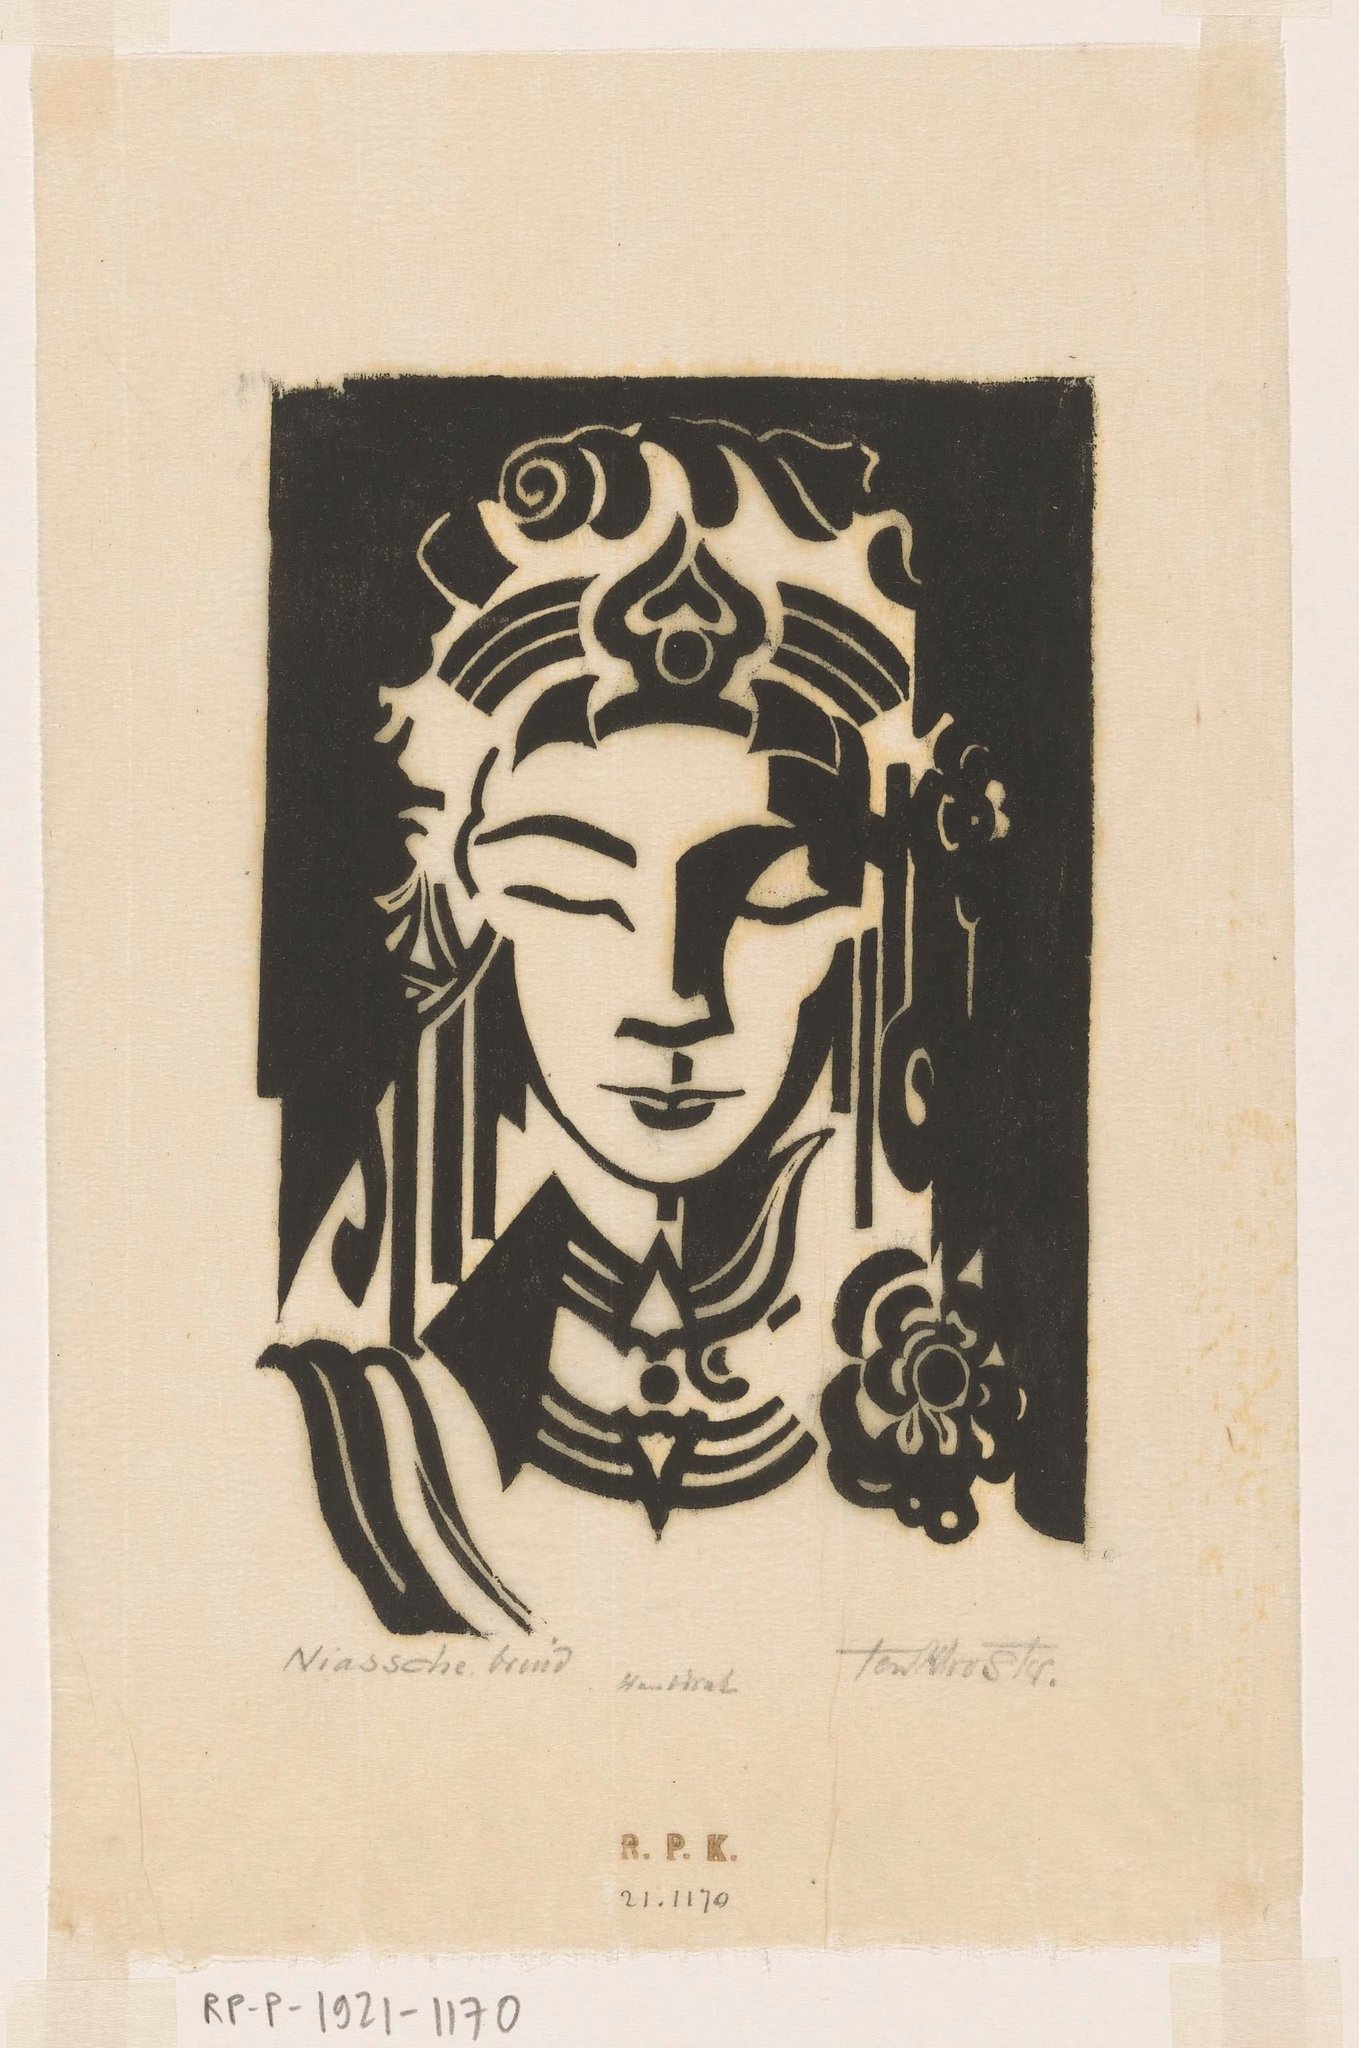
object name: print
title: Niassche bruid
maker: johannes frederik engelbert ten klooster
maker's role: draughtsman, print maker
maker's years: 1873-1940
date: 1919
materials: paper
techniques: woodcut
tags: bride (in wedding-dress)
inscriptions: collector's mark: Lugt 2233